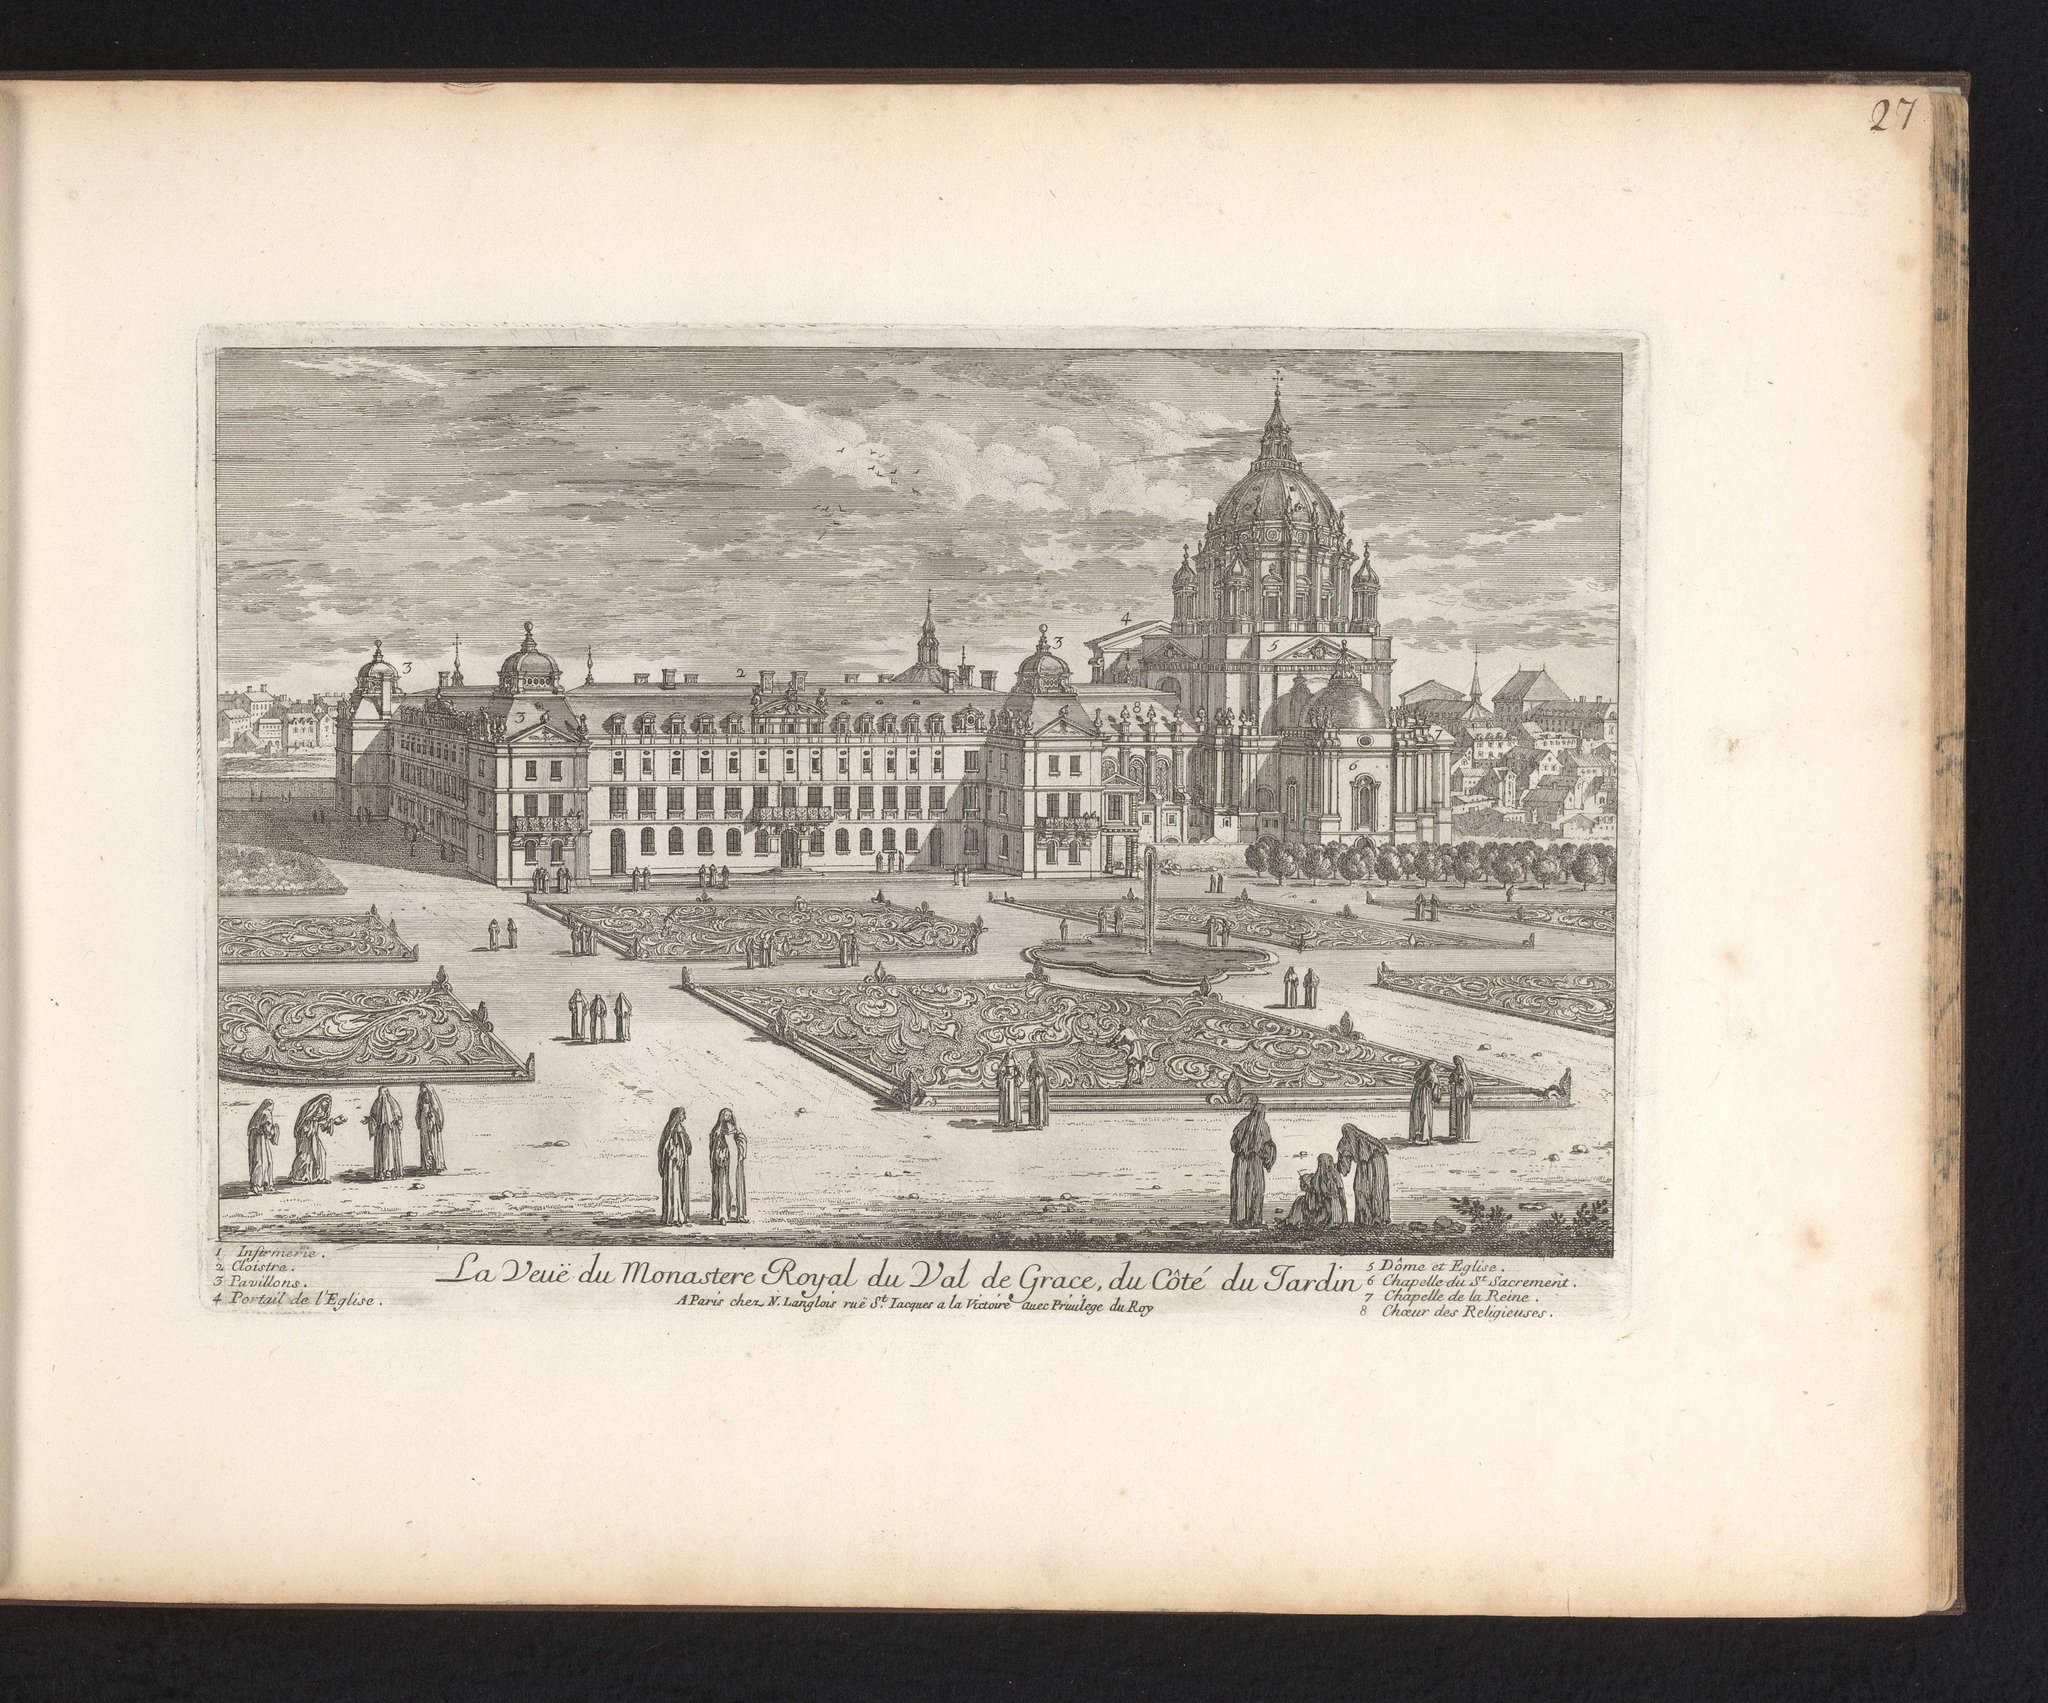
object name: album leaf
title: Recueil de vues de monuments de Paris, des principales résidences royales et des principaux châteaux de France et de Rome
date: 1668-1695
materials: paper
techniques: etching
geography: paris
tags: abbey, monastery, convent ~ roman catholic church, church (exterior)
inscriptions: collector's mark: Lugt 2228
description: Prenten met het signatuur 'Perelle' kunnen zowel door vader Gabriel als door zonen Nicolas en Adam gemaakt zijn. De uitgevers vader en zoon Nicolas Langlois worden allebei vermeld als N. Langlois op hetzelfde adres.